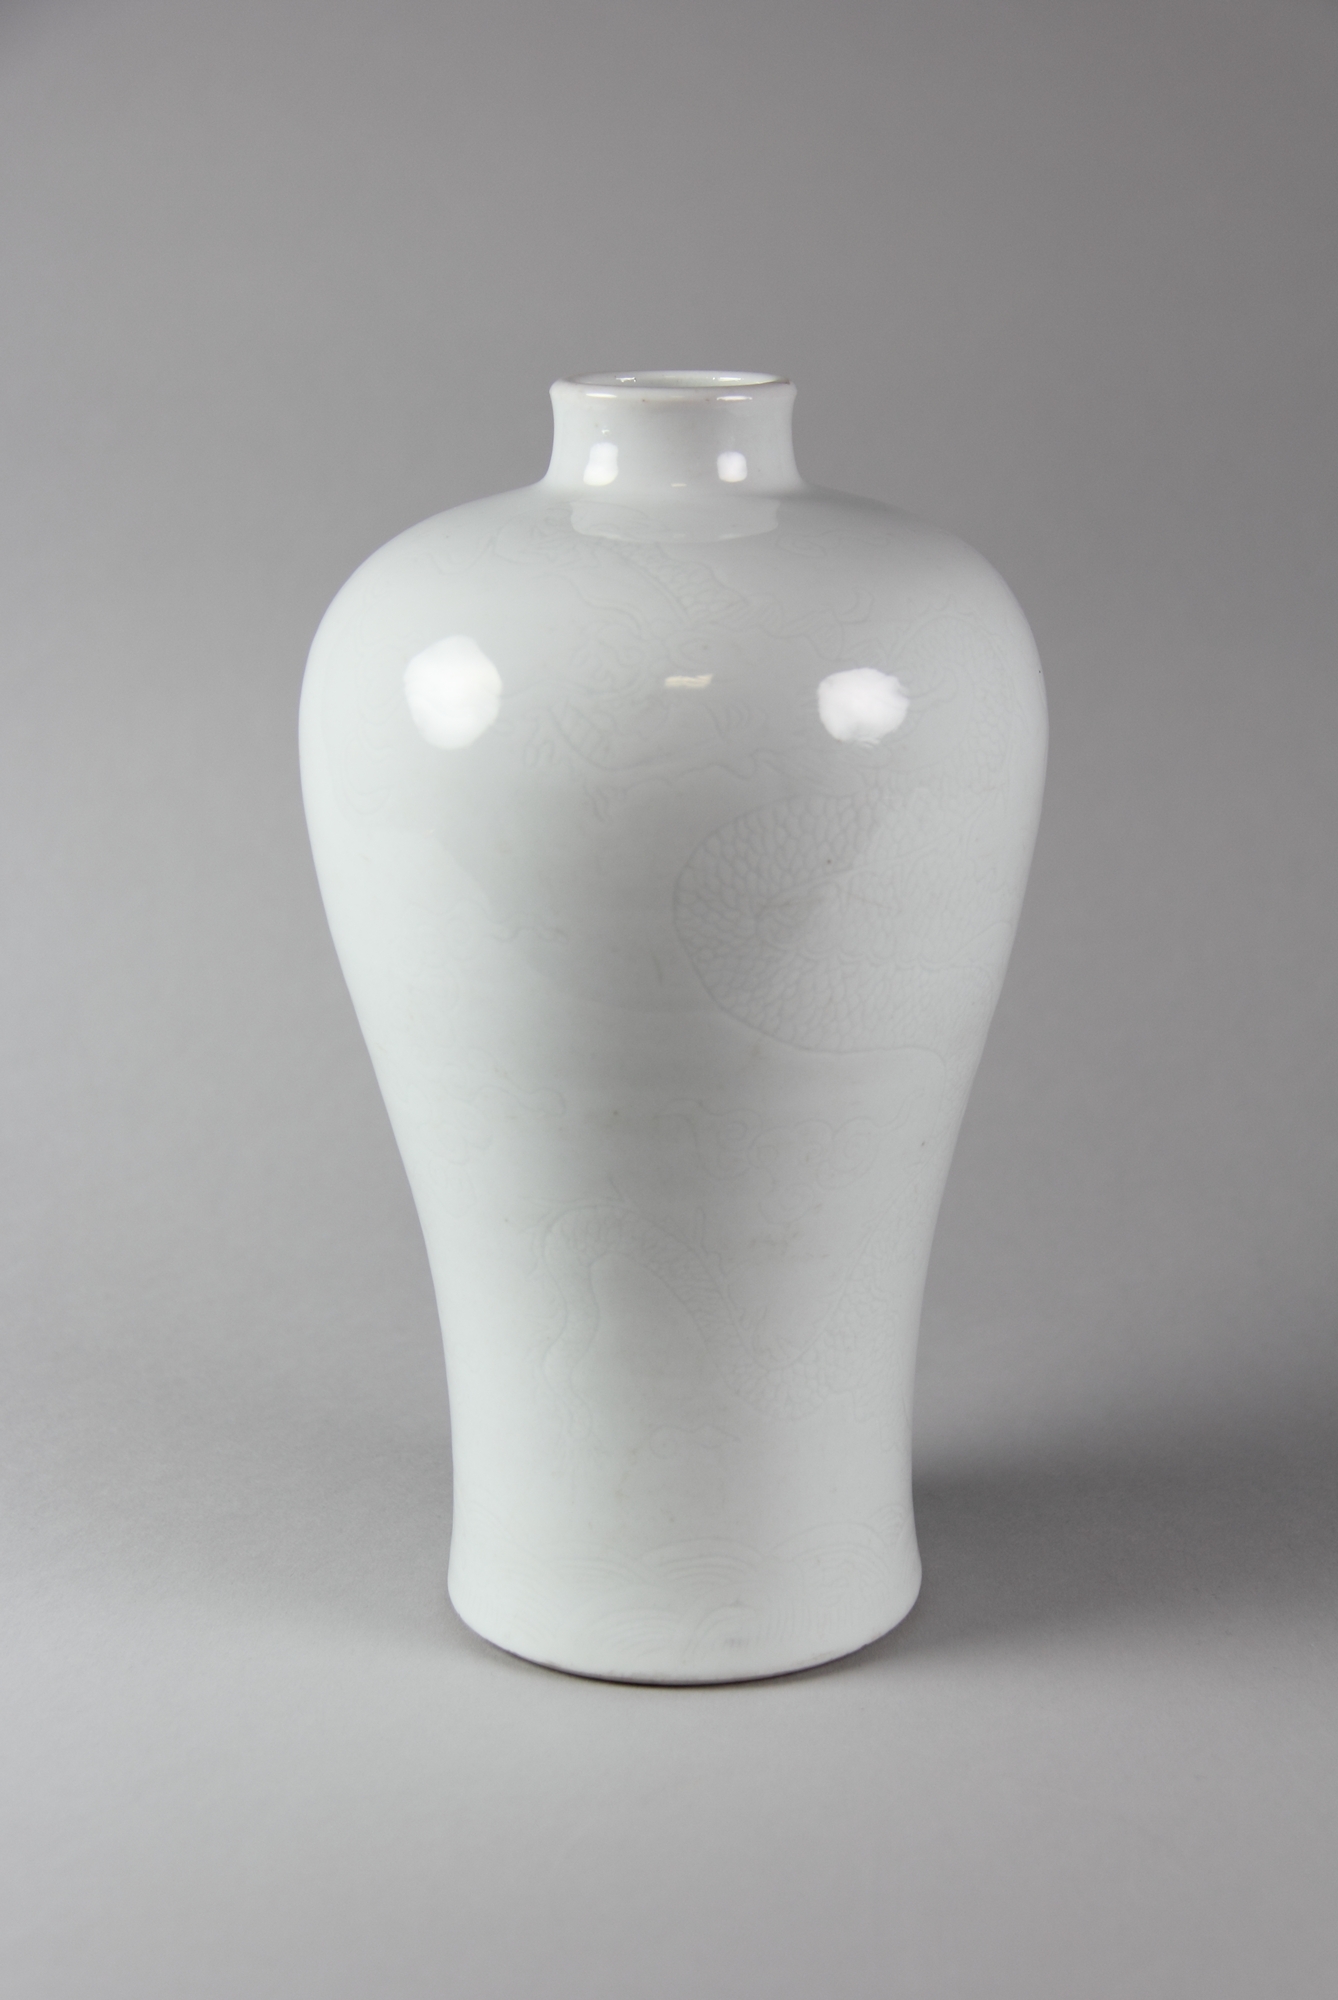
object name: vase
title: Meiping vase with dragon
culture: chinese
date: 1667-1733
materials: porcelain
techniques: incising